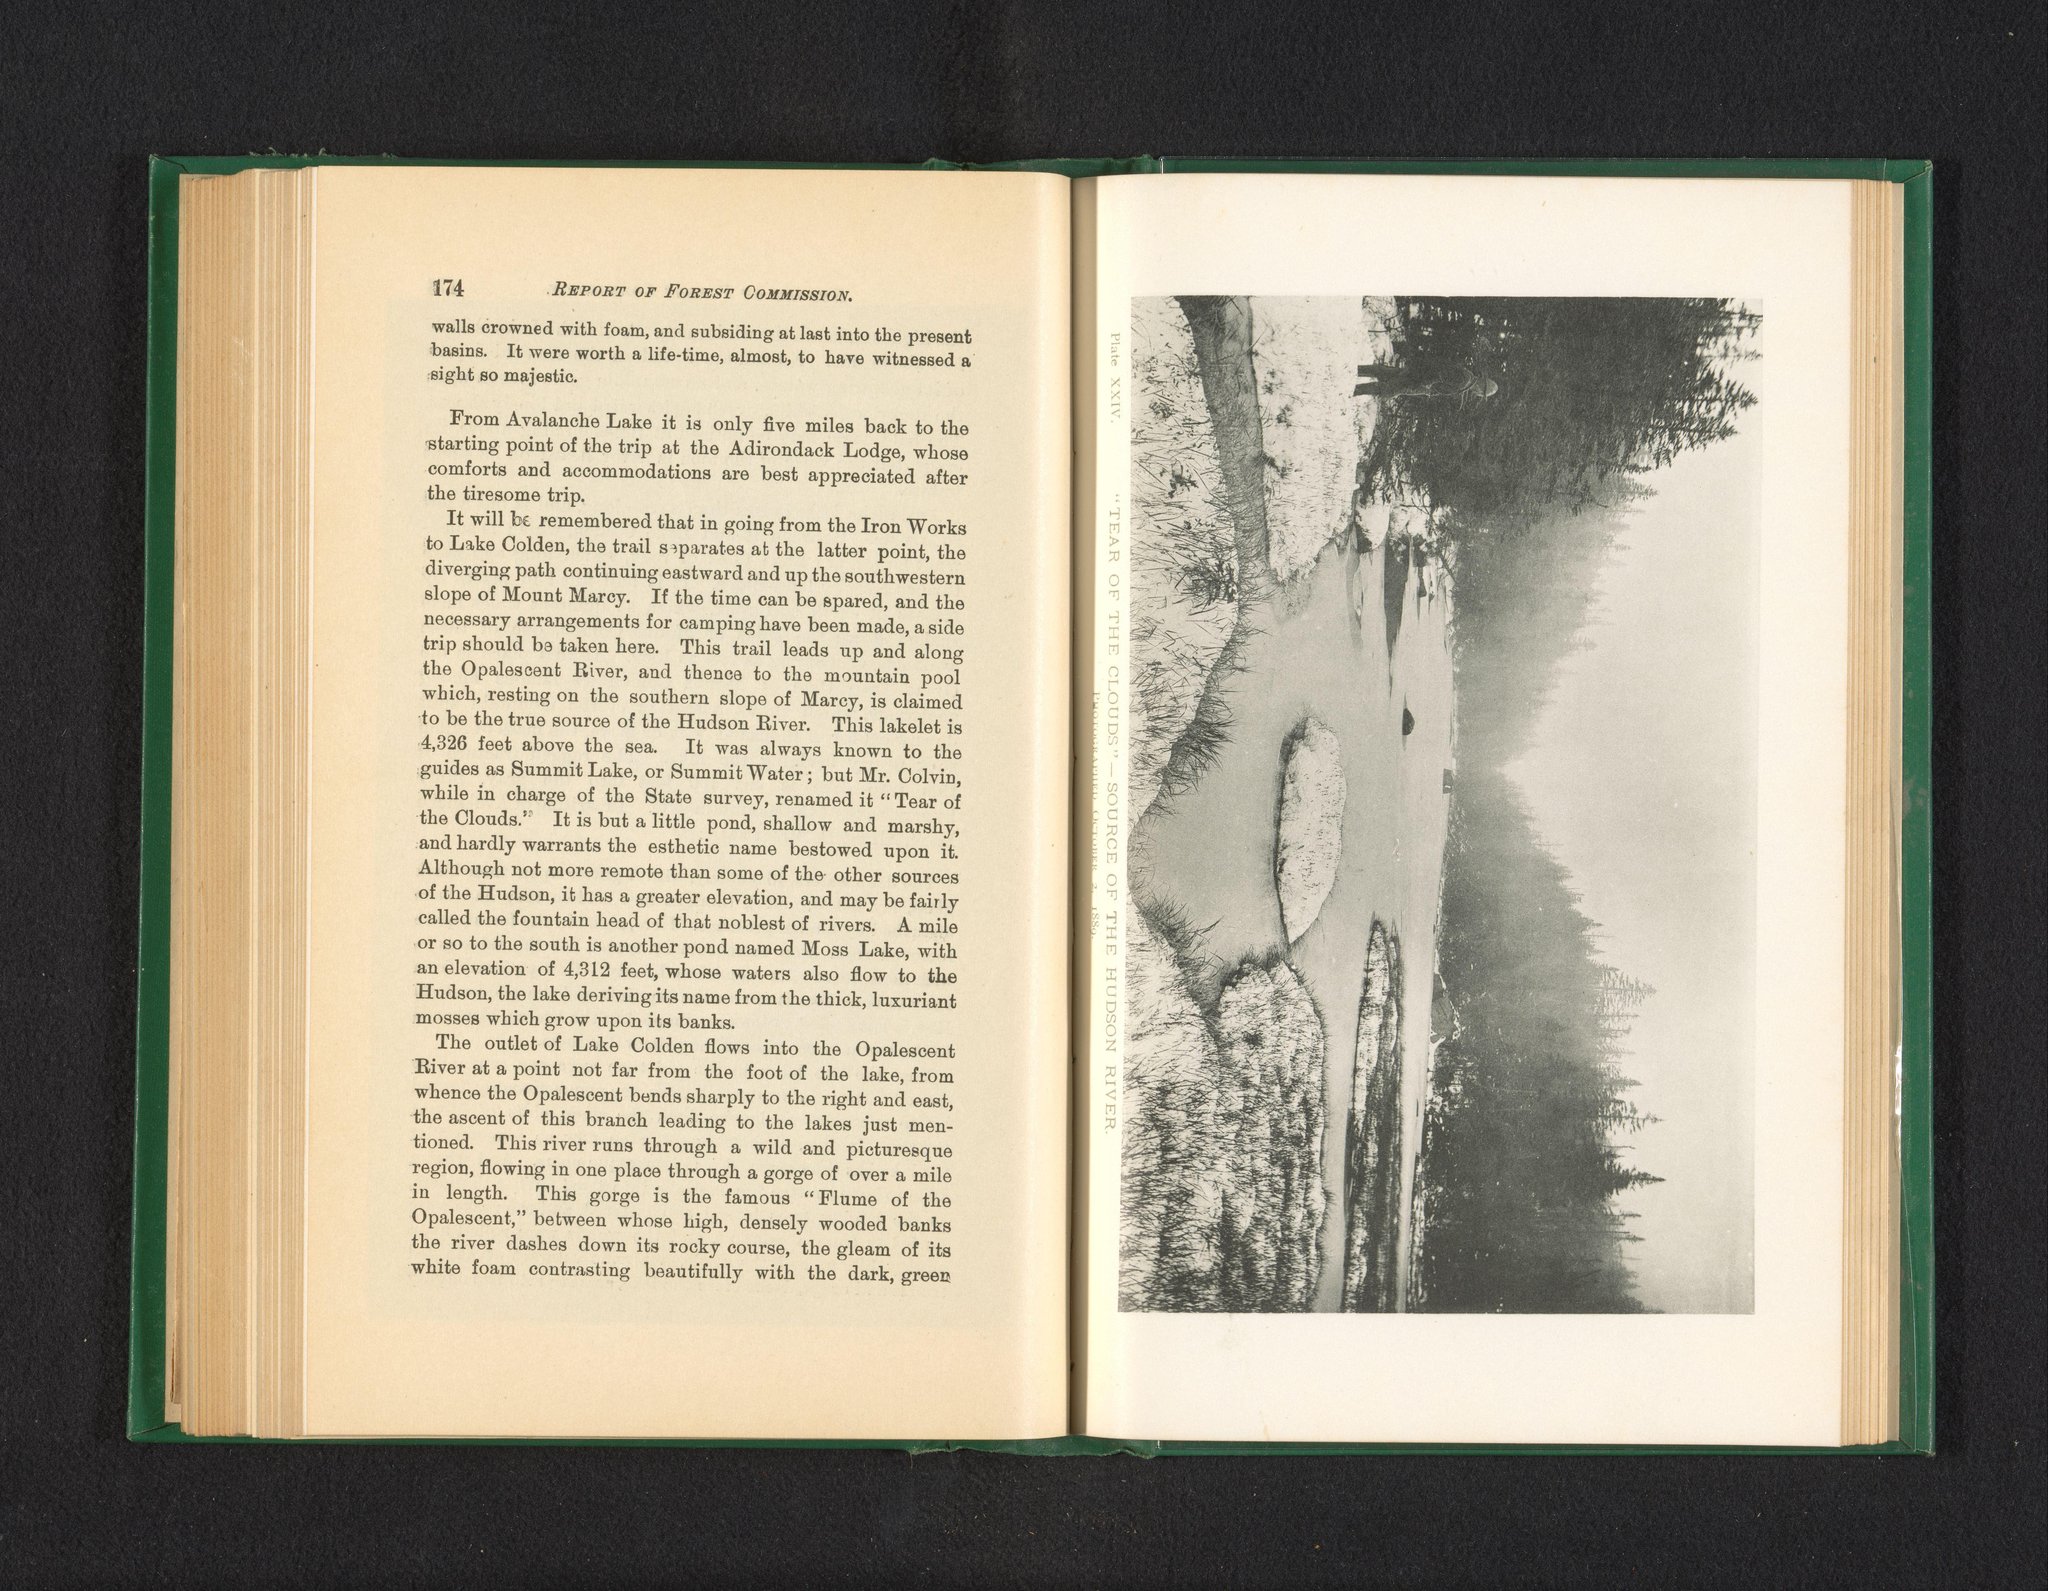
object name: page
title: "Tear of the clouds"-Source of the Hudson River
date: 1891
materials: paper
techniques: photograph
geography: new york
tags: lake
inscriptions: number: ‘Plate XXIV.’